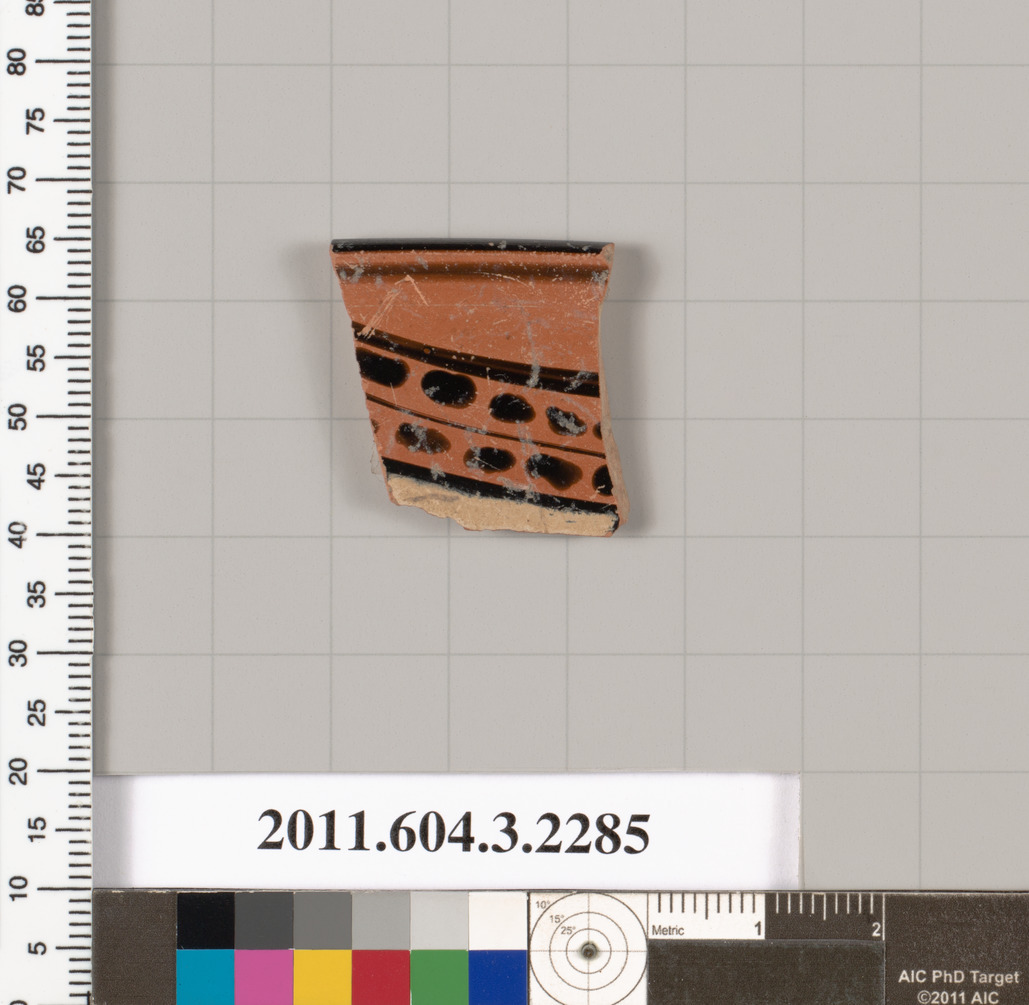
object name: kylix fragment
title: Terracotta rim fragment of a kylix: eye-cup (drinking cup)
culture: greek, attic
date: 530 BCE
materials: terracotta